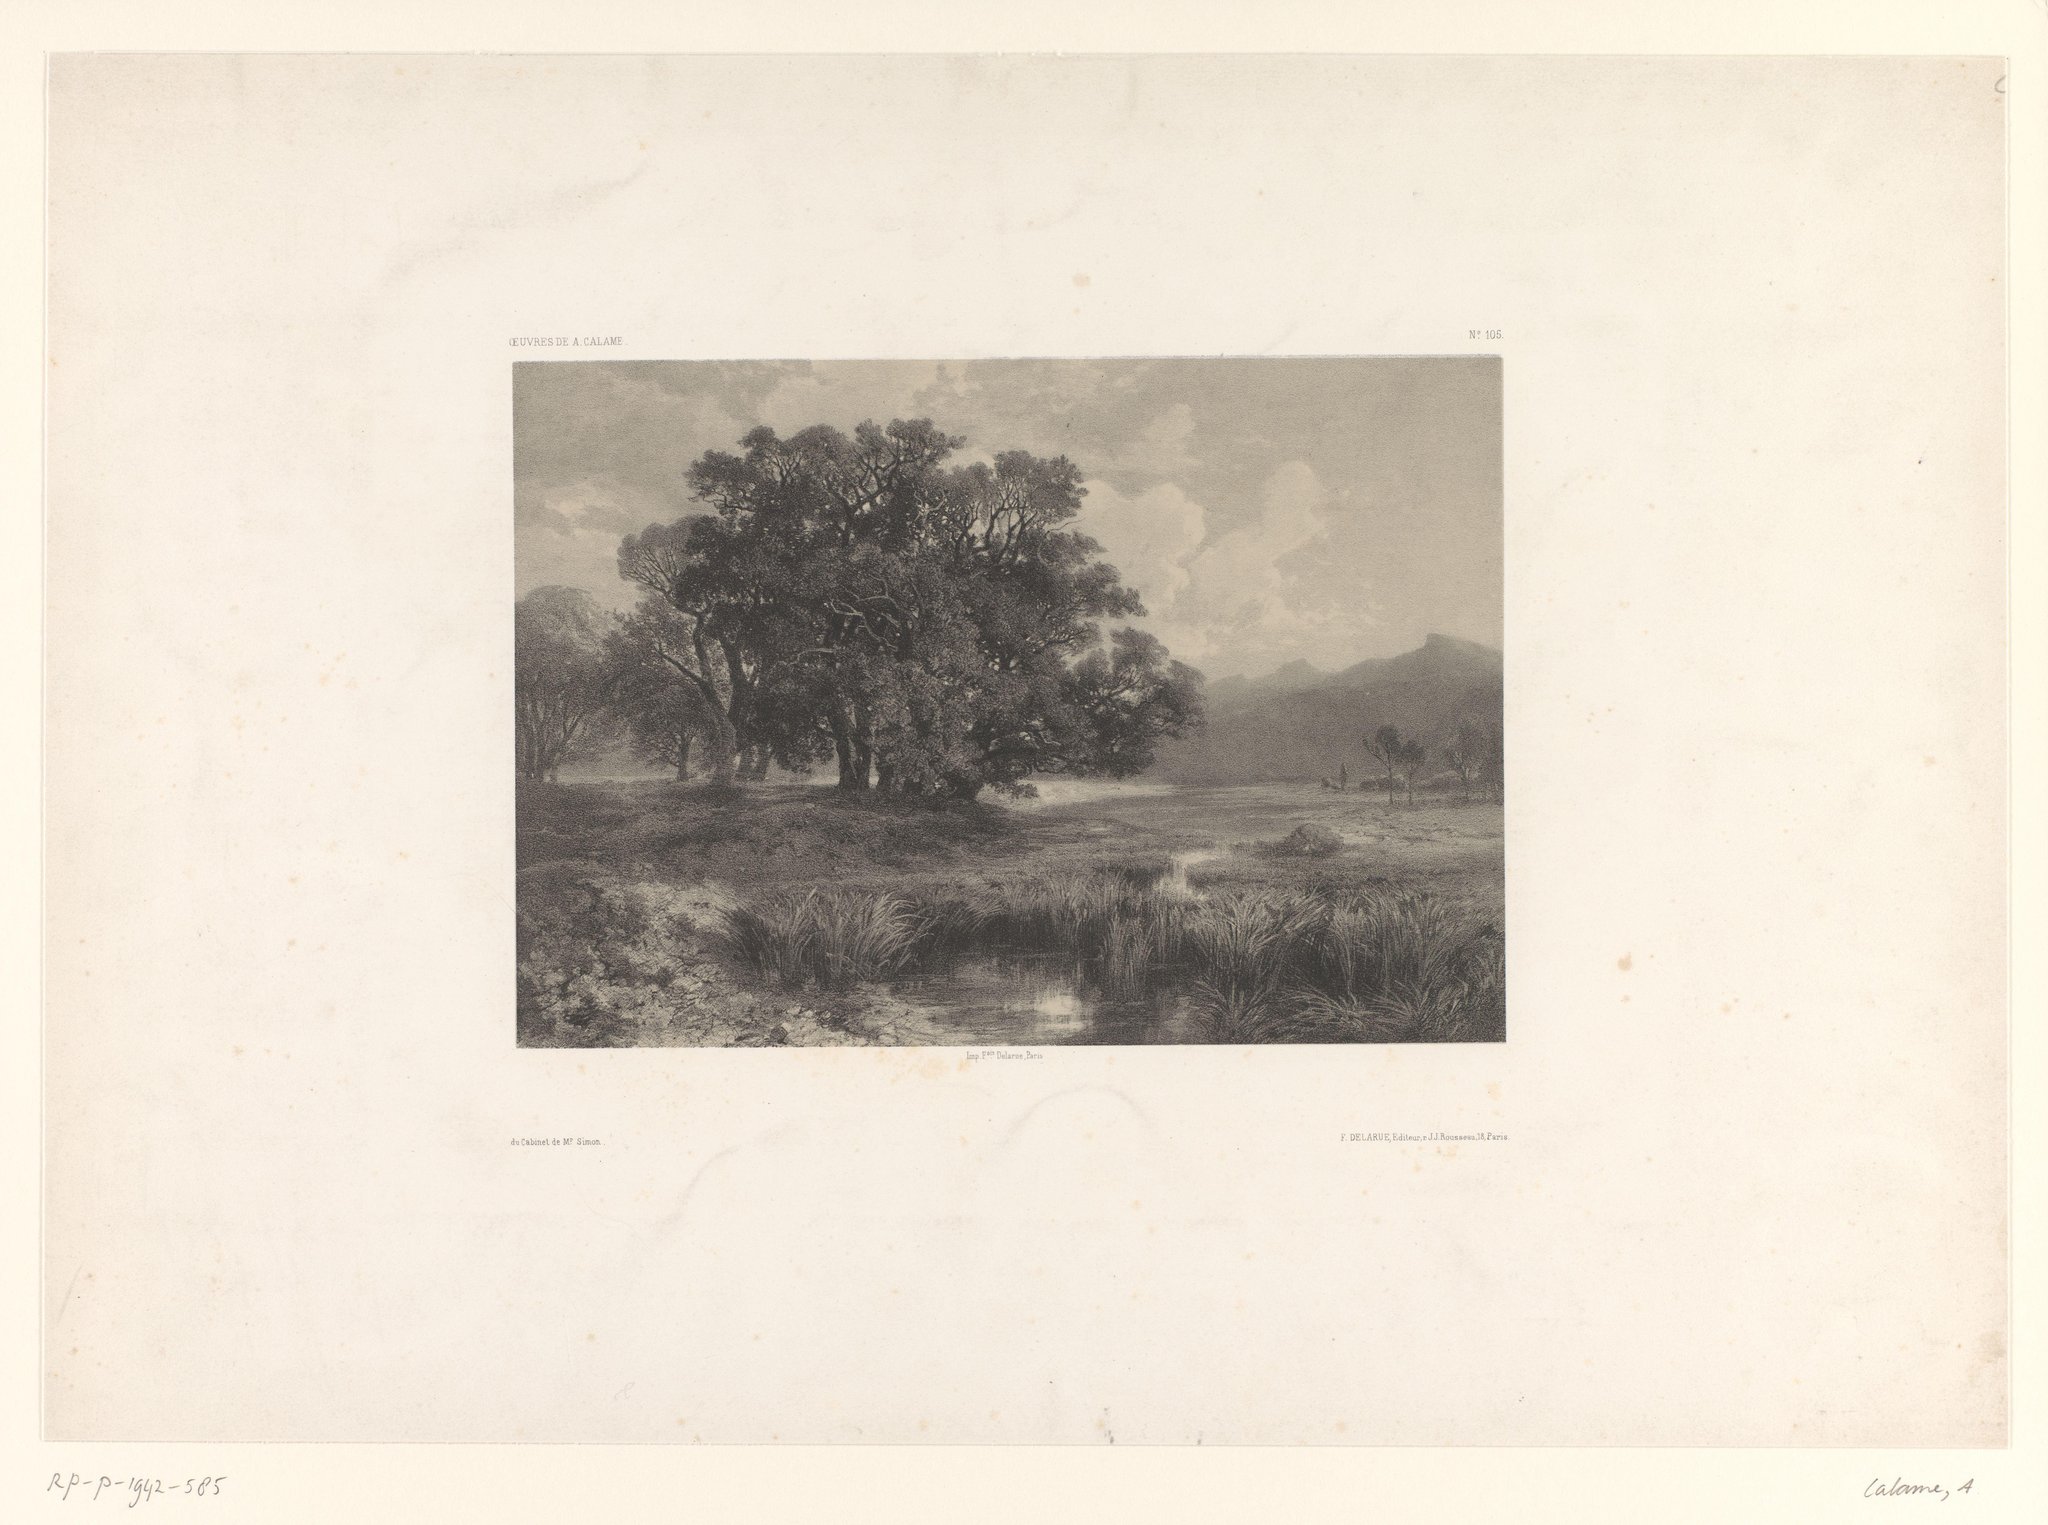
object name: print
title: Berglandschap met boomgroep bij een ven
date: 1852-1855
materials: paper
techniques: lithograph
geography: paris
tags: trees, fen, du. 'ven', mountains